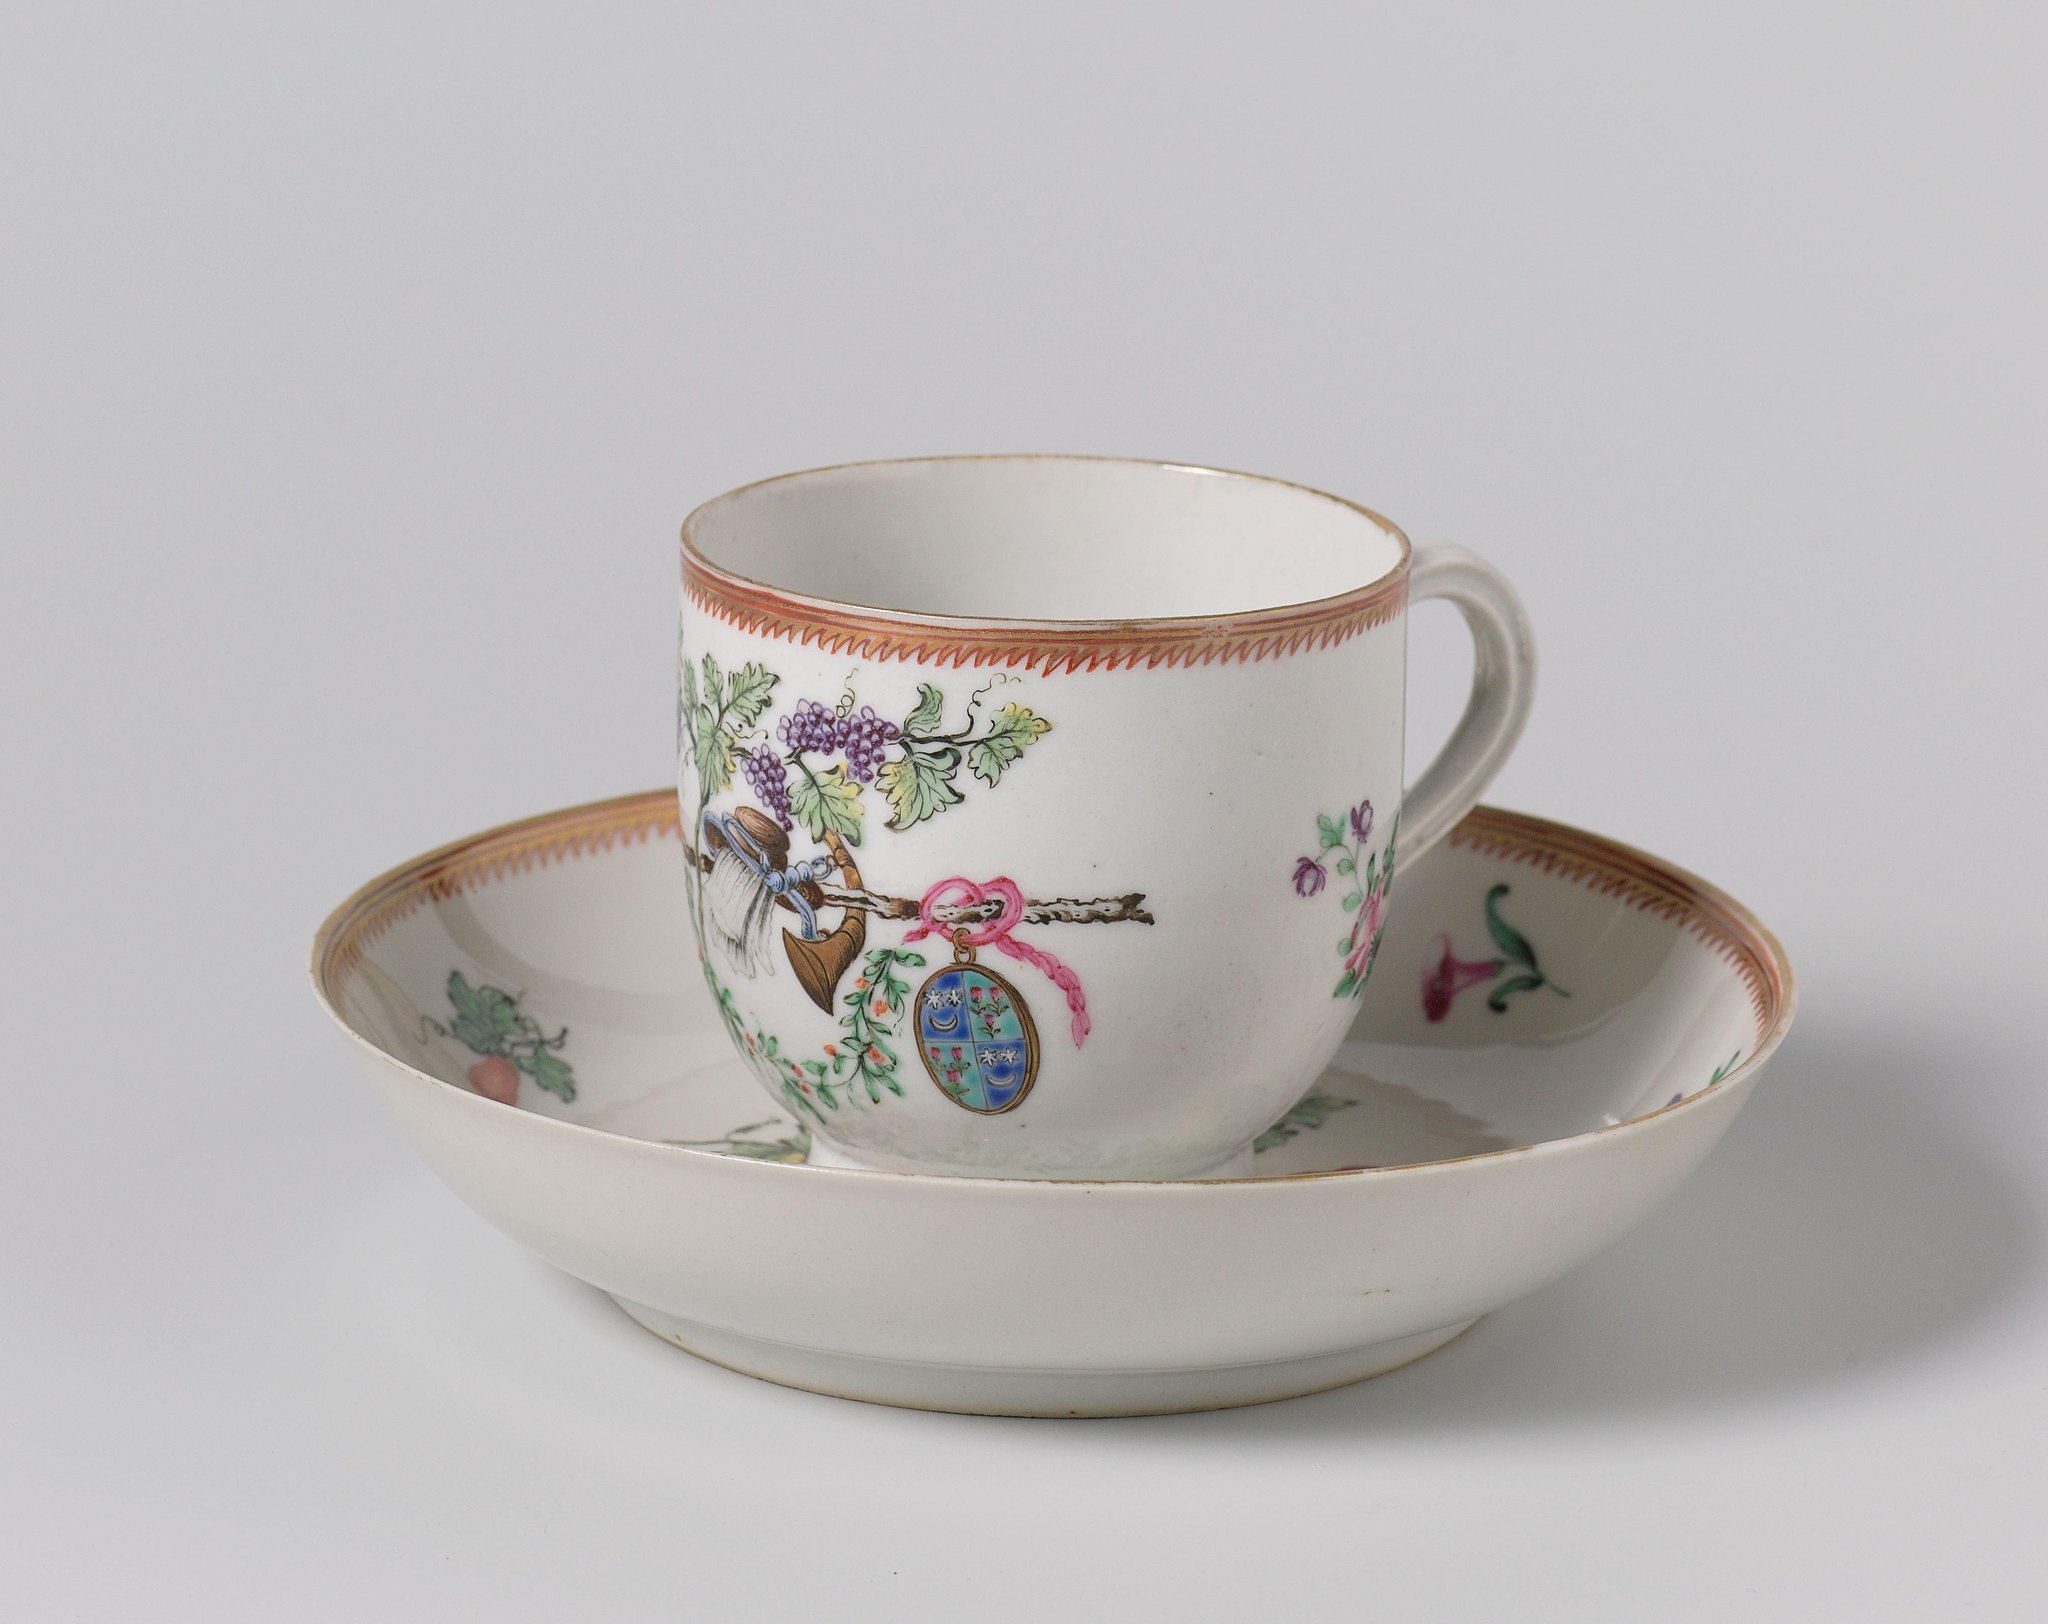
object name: cup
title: Cup with handle with the arms of the Visvliet and Sluymer families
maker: Anonymous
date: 1777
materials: glaze, gold, paint, porcelain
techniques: firing, gilding, turning, vitrification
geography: china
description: Kop en schotel van porselein. Versierd met bloem- en vruchtentakken en een stok waaraan een hoed, een blad papier een hoorn en 2 wapenschilden zijn bevestigd. De wapens zijn van de families Visvliet en Sluymer (uit Zeeland).